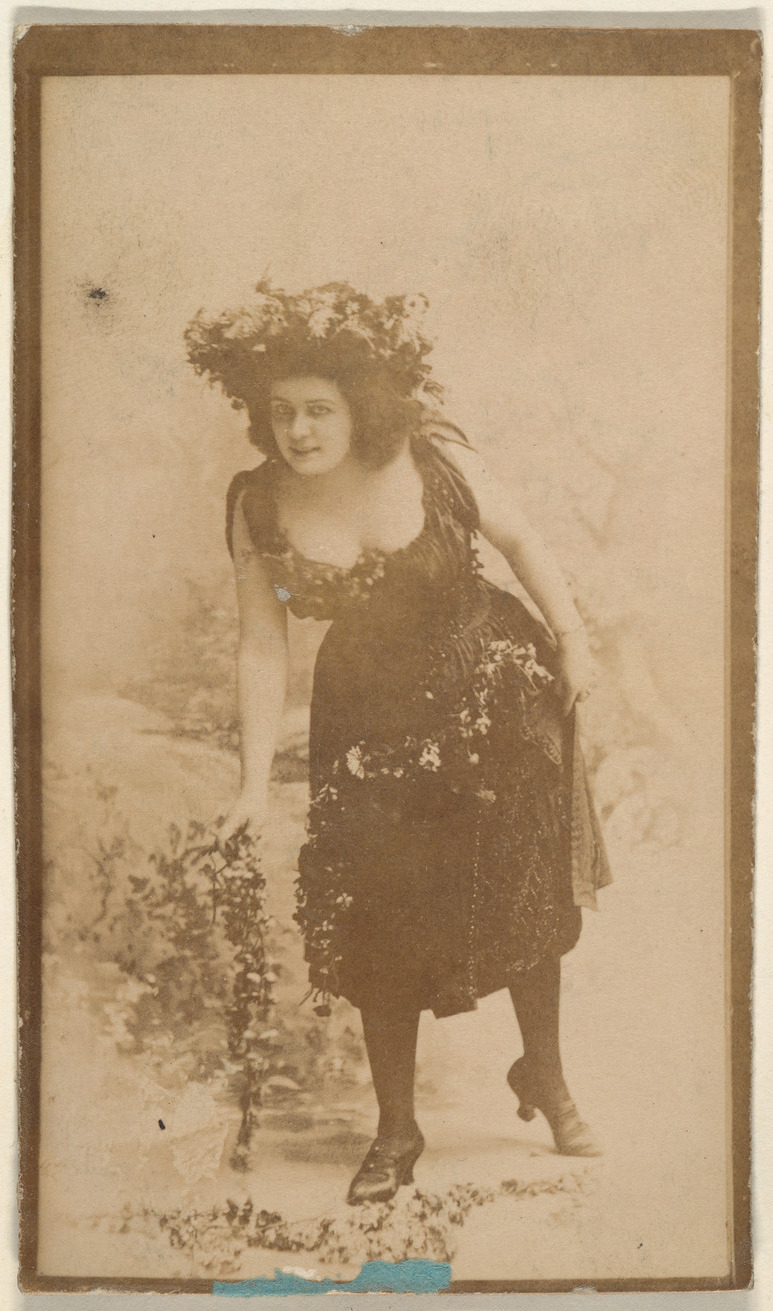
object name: photograph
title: Actress wearing costume with floral headpiece, from the Actresses series (N668)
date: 1888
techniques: albumen silver print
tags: portraits,women,actresses